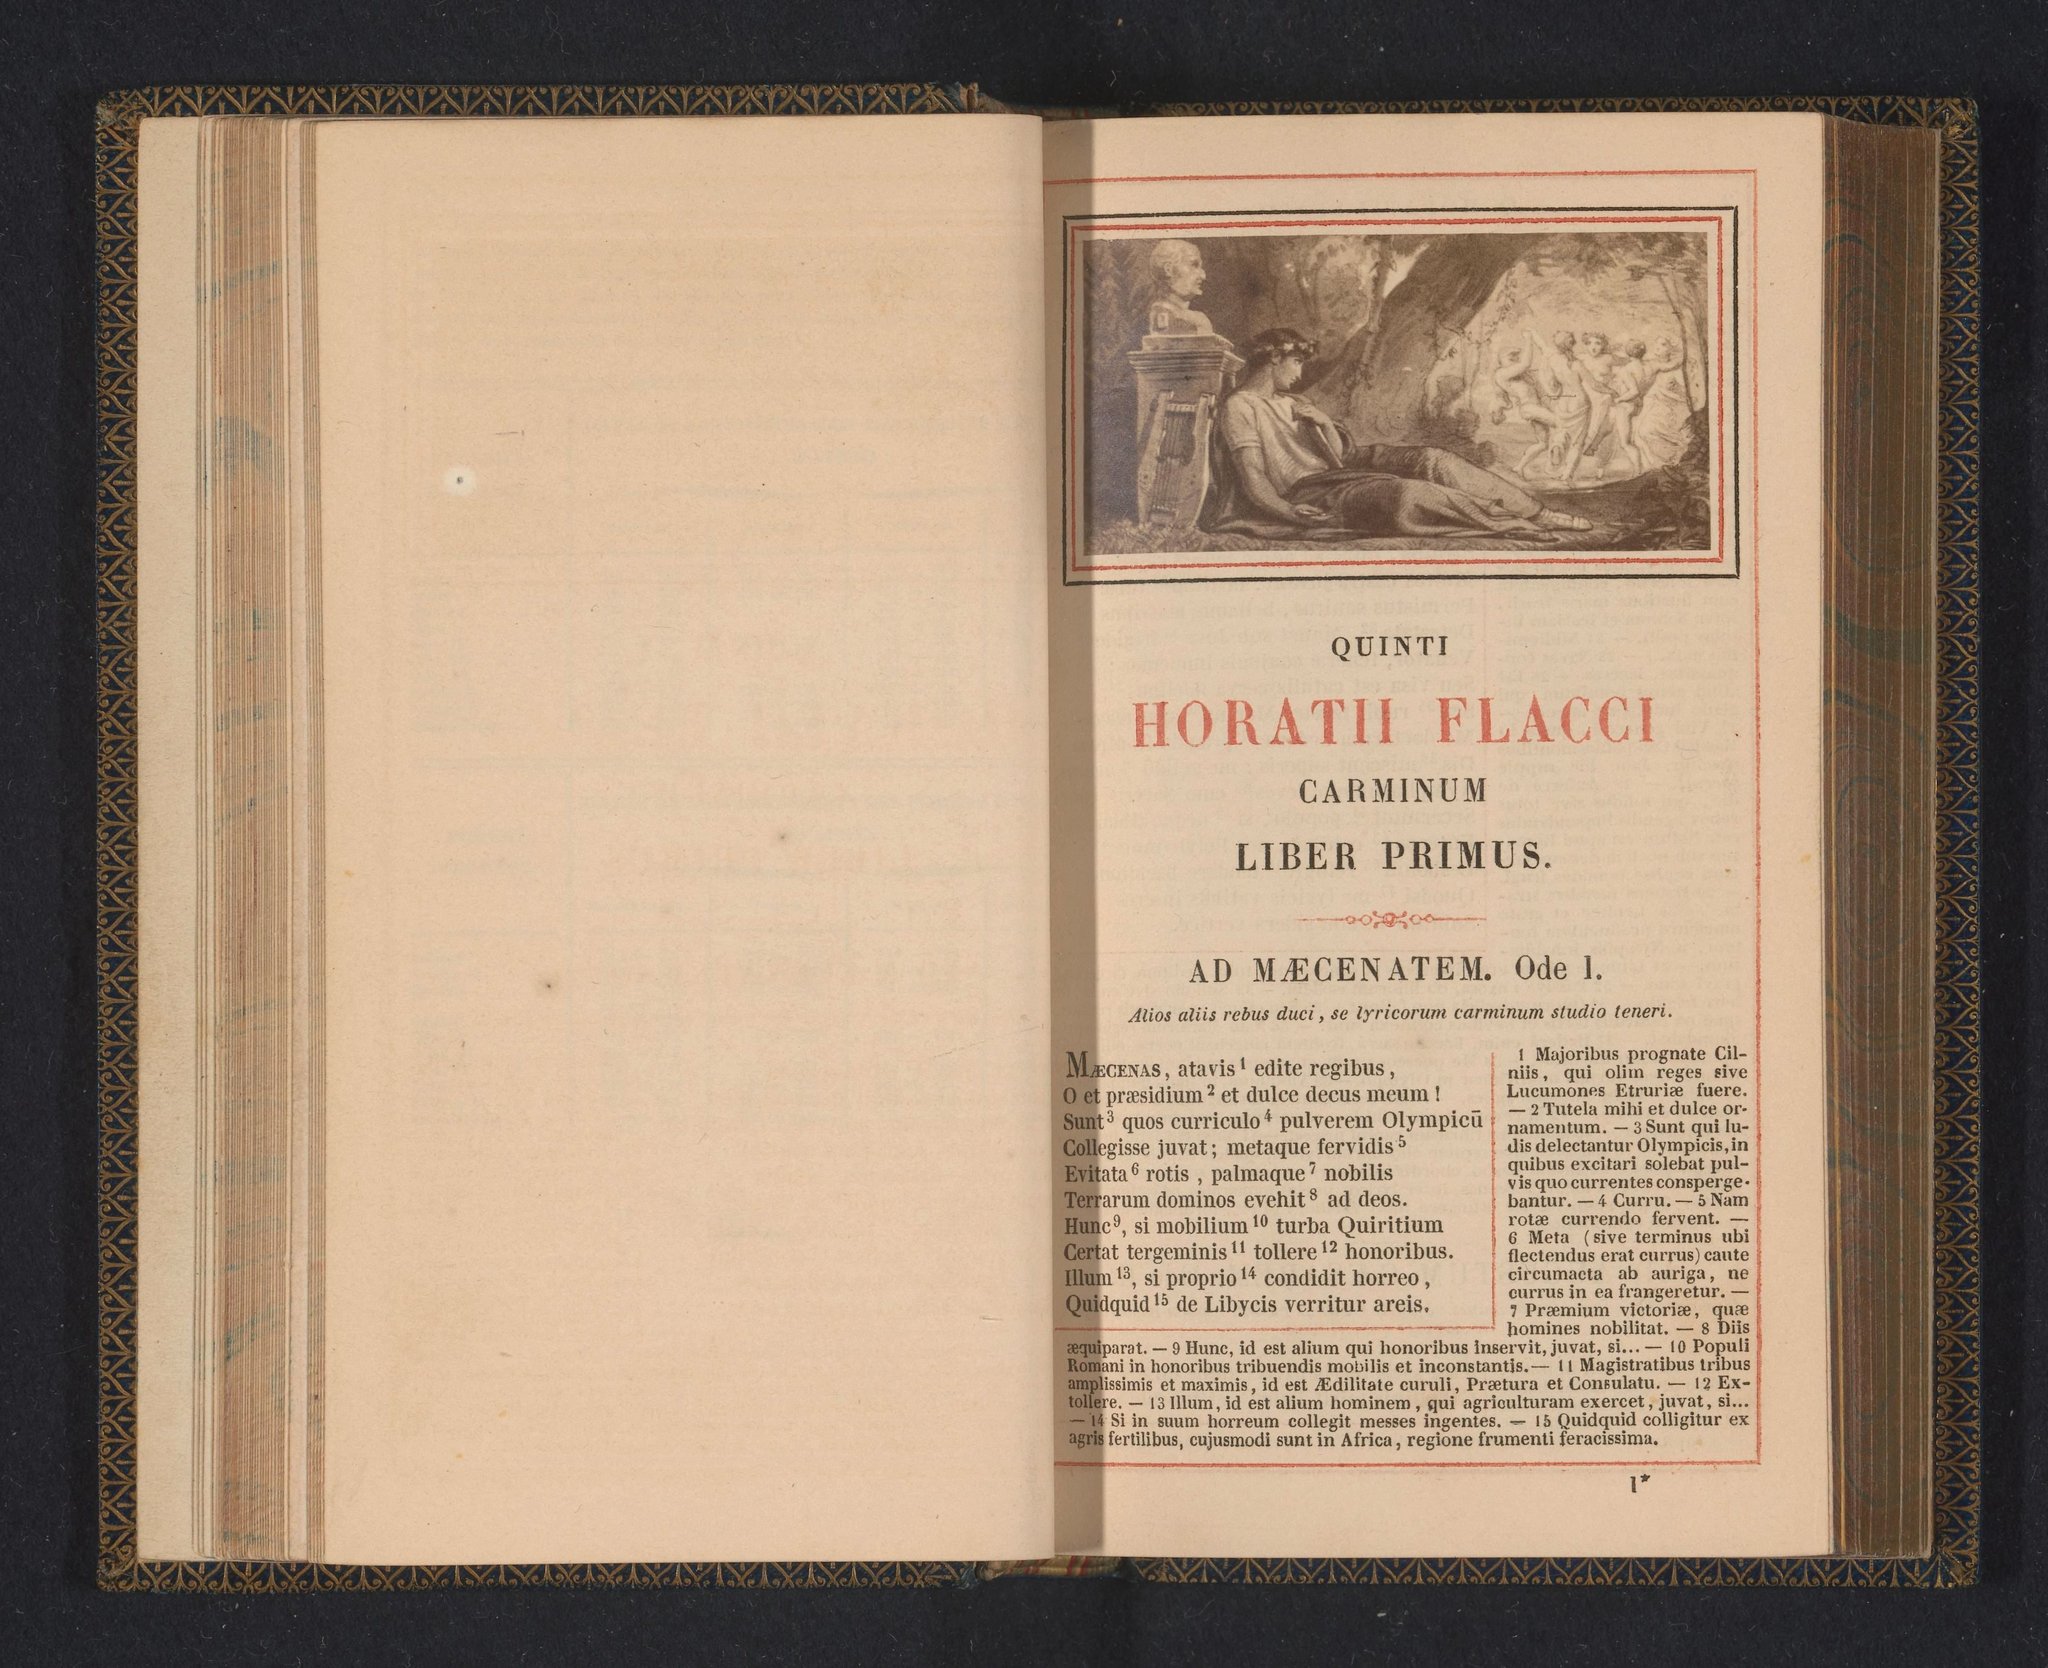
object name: reproduction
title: Fotoreproductie van een schilderij, voorstellende een liggende jongeman met een harp naast een reliëf met dansende figuren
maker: Anonymous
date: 1850-1855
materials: photographic support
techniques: albumen print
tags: harp, lying figure, sculpture (+ relief ~ sculpture)